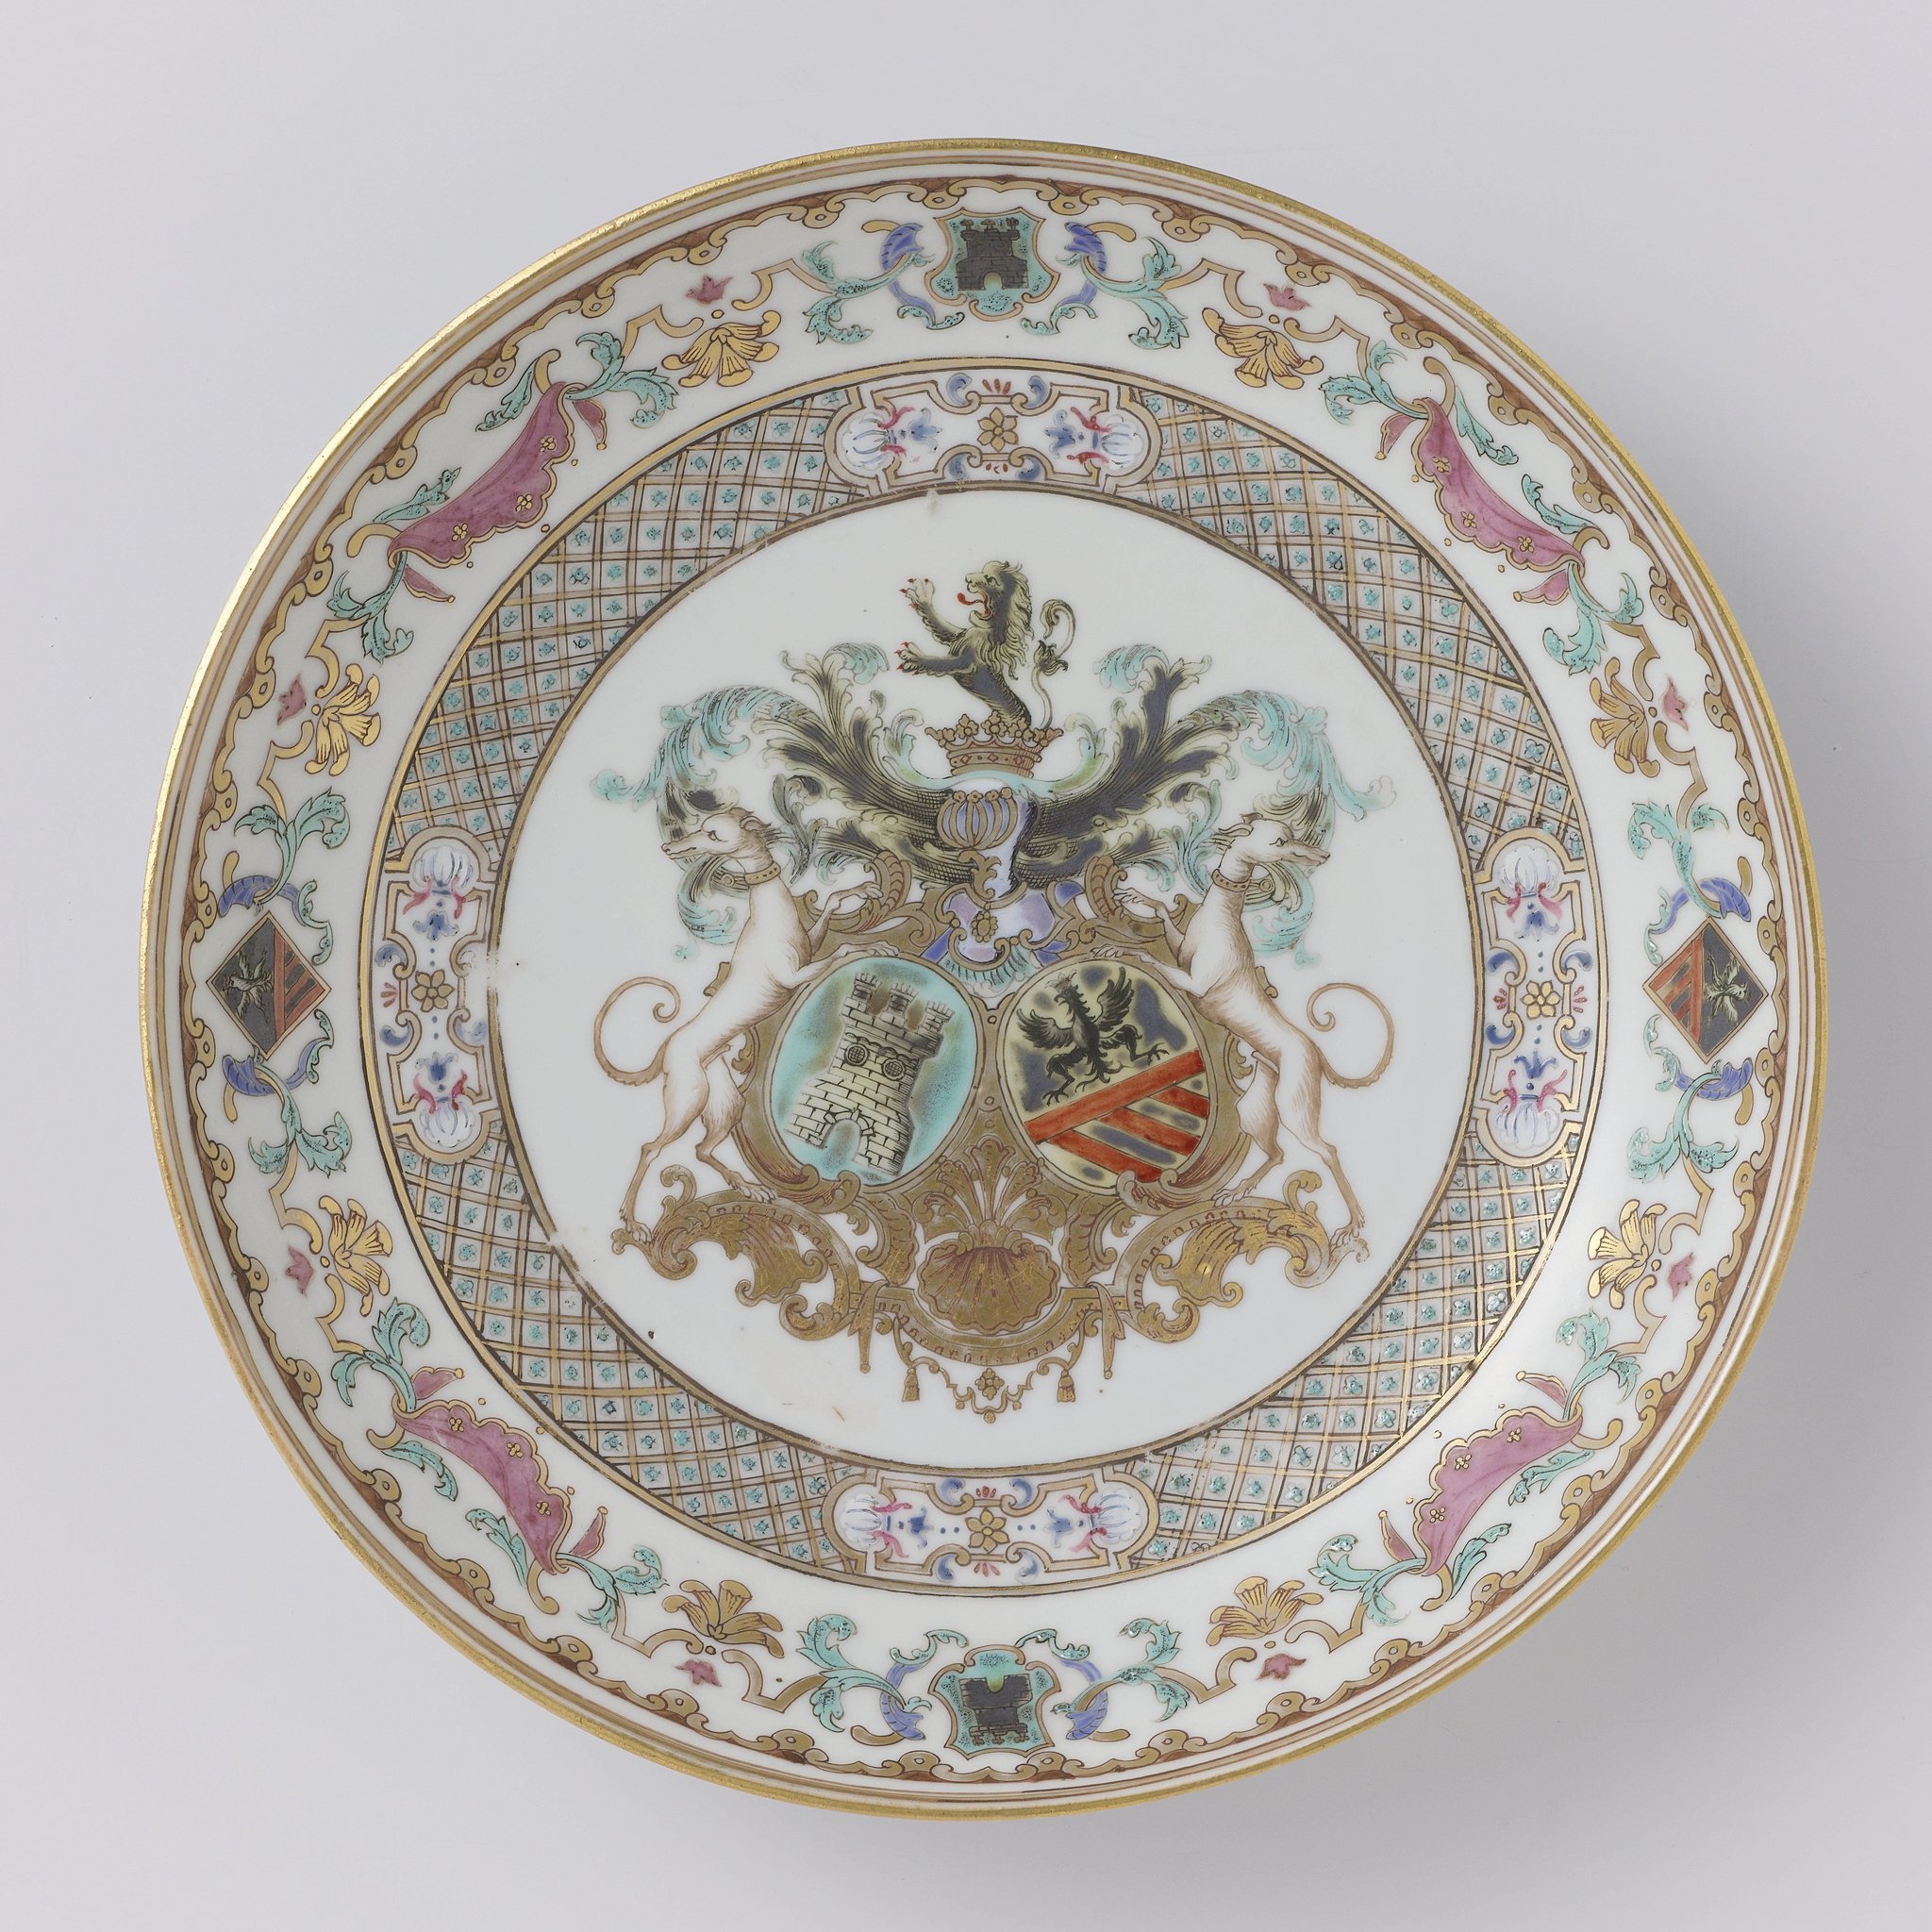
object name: plate dish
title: Soup plate with the coat of arms of the De La Bistrate and Proli families, diaper pattern and European ornamental border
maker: Anonymous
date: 1740-1760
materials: glaze, gold, paint, porcelain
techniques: firing, gilding, turning, vitrification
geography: china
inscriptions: label: ‘de la Bistrate (Anvers)/ (An 11 fev: 1682) De sin à la tour sommèe de trois tourelles d'arg: Gd. cour. G.: un lion iss. d'arg, arm et lamp de gu. S: deux lévriers, du nat. - Proli (Brab.)/ orig. de Milan (An 17 nov: 1727) Coupe: au 1 d'arg à l'aigle de sd, cour. d'arg souteune d'une divise de gu; au 2 d'arg à trois bandes de gu.'’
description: Soepbord van porselein, beschilderd op het glazuur in blauw, rood, roze, geel, turquoise, zwart en goud. Op het plat een gekroond dubbel wapen van de families De La Bistrate en Proli geflankeerd door windhonden, bladranken en een leeuw. In een wapen een toren, de ander met een gekroonde arend en rode, schuine lijnen. Om het wapen een band met servetwerk afgewisseld met cartouches. Op de wand een Europese decoratieve band waarin de wapens zijn verwerkt. Oud label op de onderzijde met in het Frans 'de la Bistrate (Anvers)/ (An 11 fev: 1682) De sin à la tour sommèe de trois tourelles d'arg: Gd. cour. G.: un lion iss. d'arg, arm et lamp de gu. S: deux lévriers, du nat. - Proli (Brab.) orig. de Milan (An 17 nov: 1727) Coupe: au 1 d'arg à l'aigle de sd, cour. d'arg souteune d'une divise de gu; au 2 d'arg à trois bandes de gu.' Wapenporselein met emailkleuren.